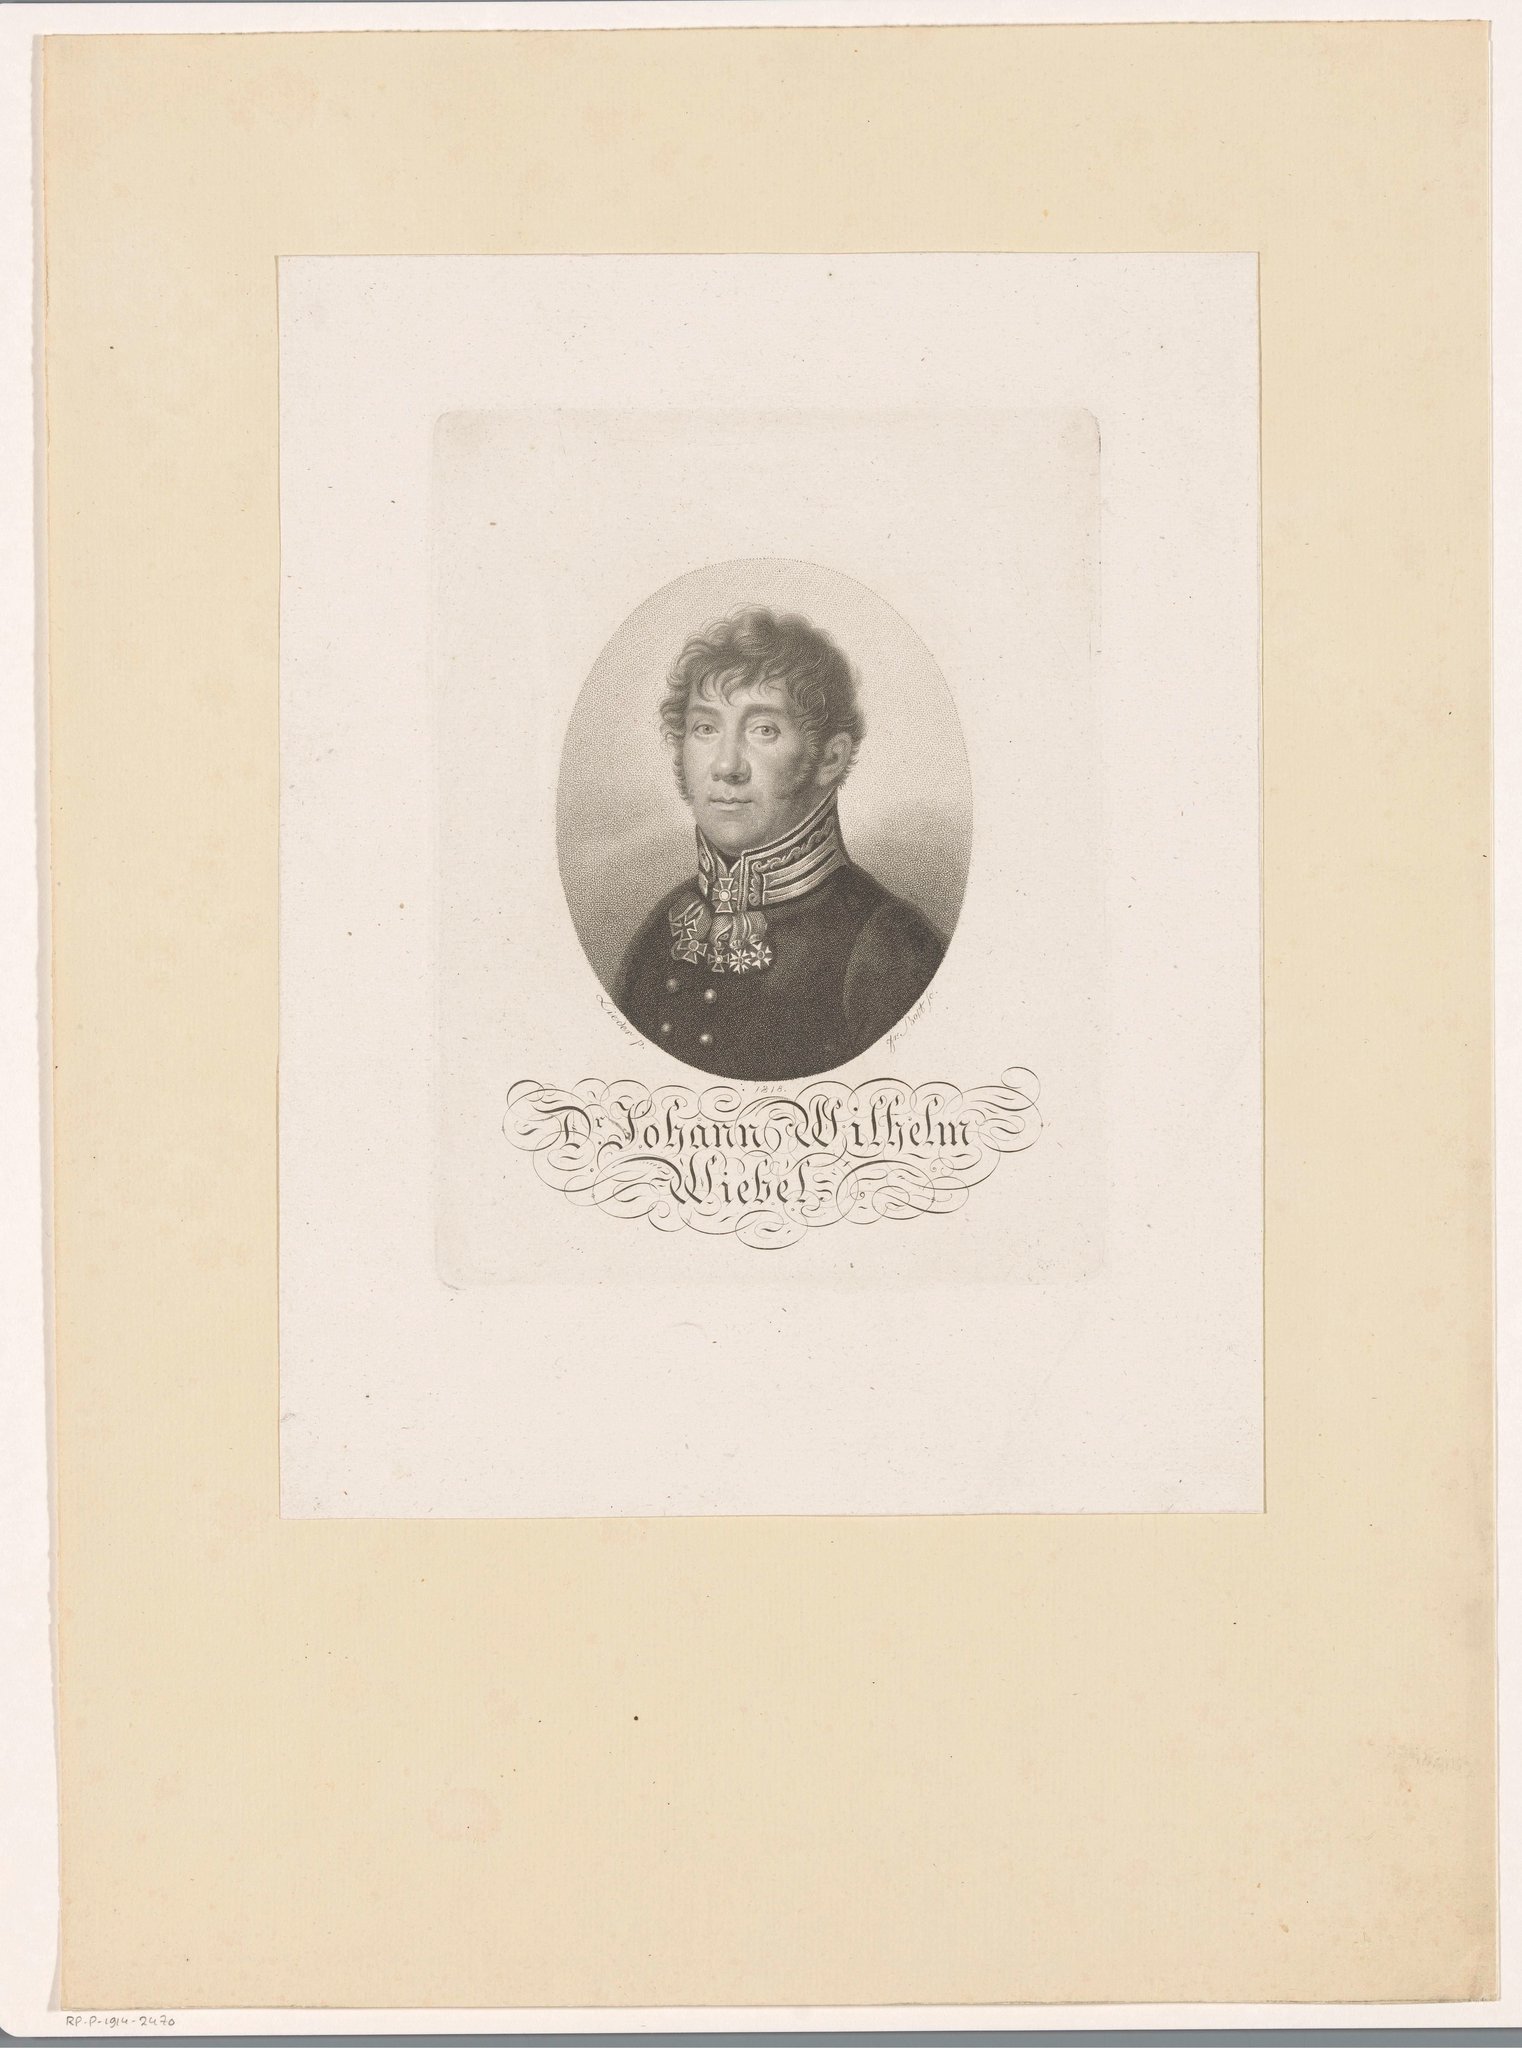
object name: print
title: Portret van Johann Wilhelm von Wiebel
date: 1818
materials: paper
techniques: stippling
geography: berlin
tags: berlin, knighthood order, historical persons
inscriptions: date